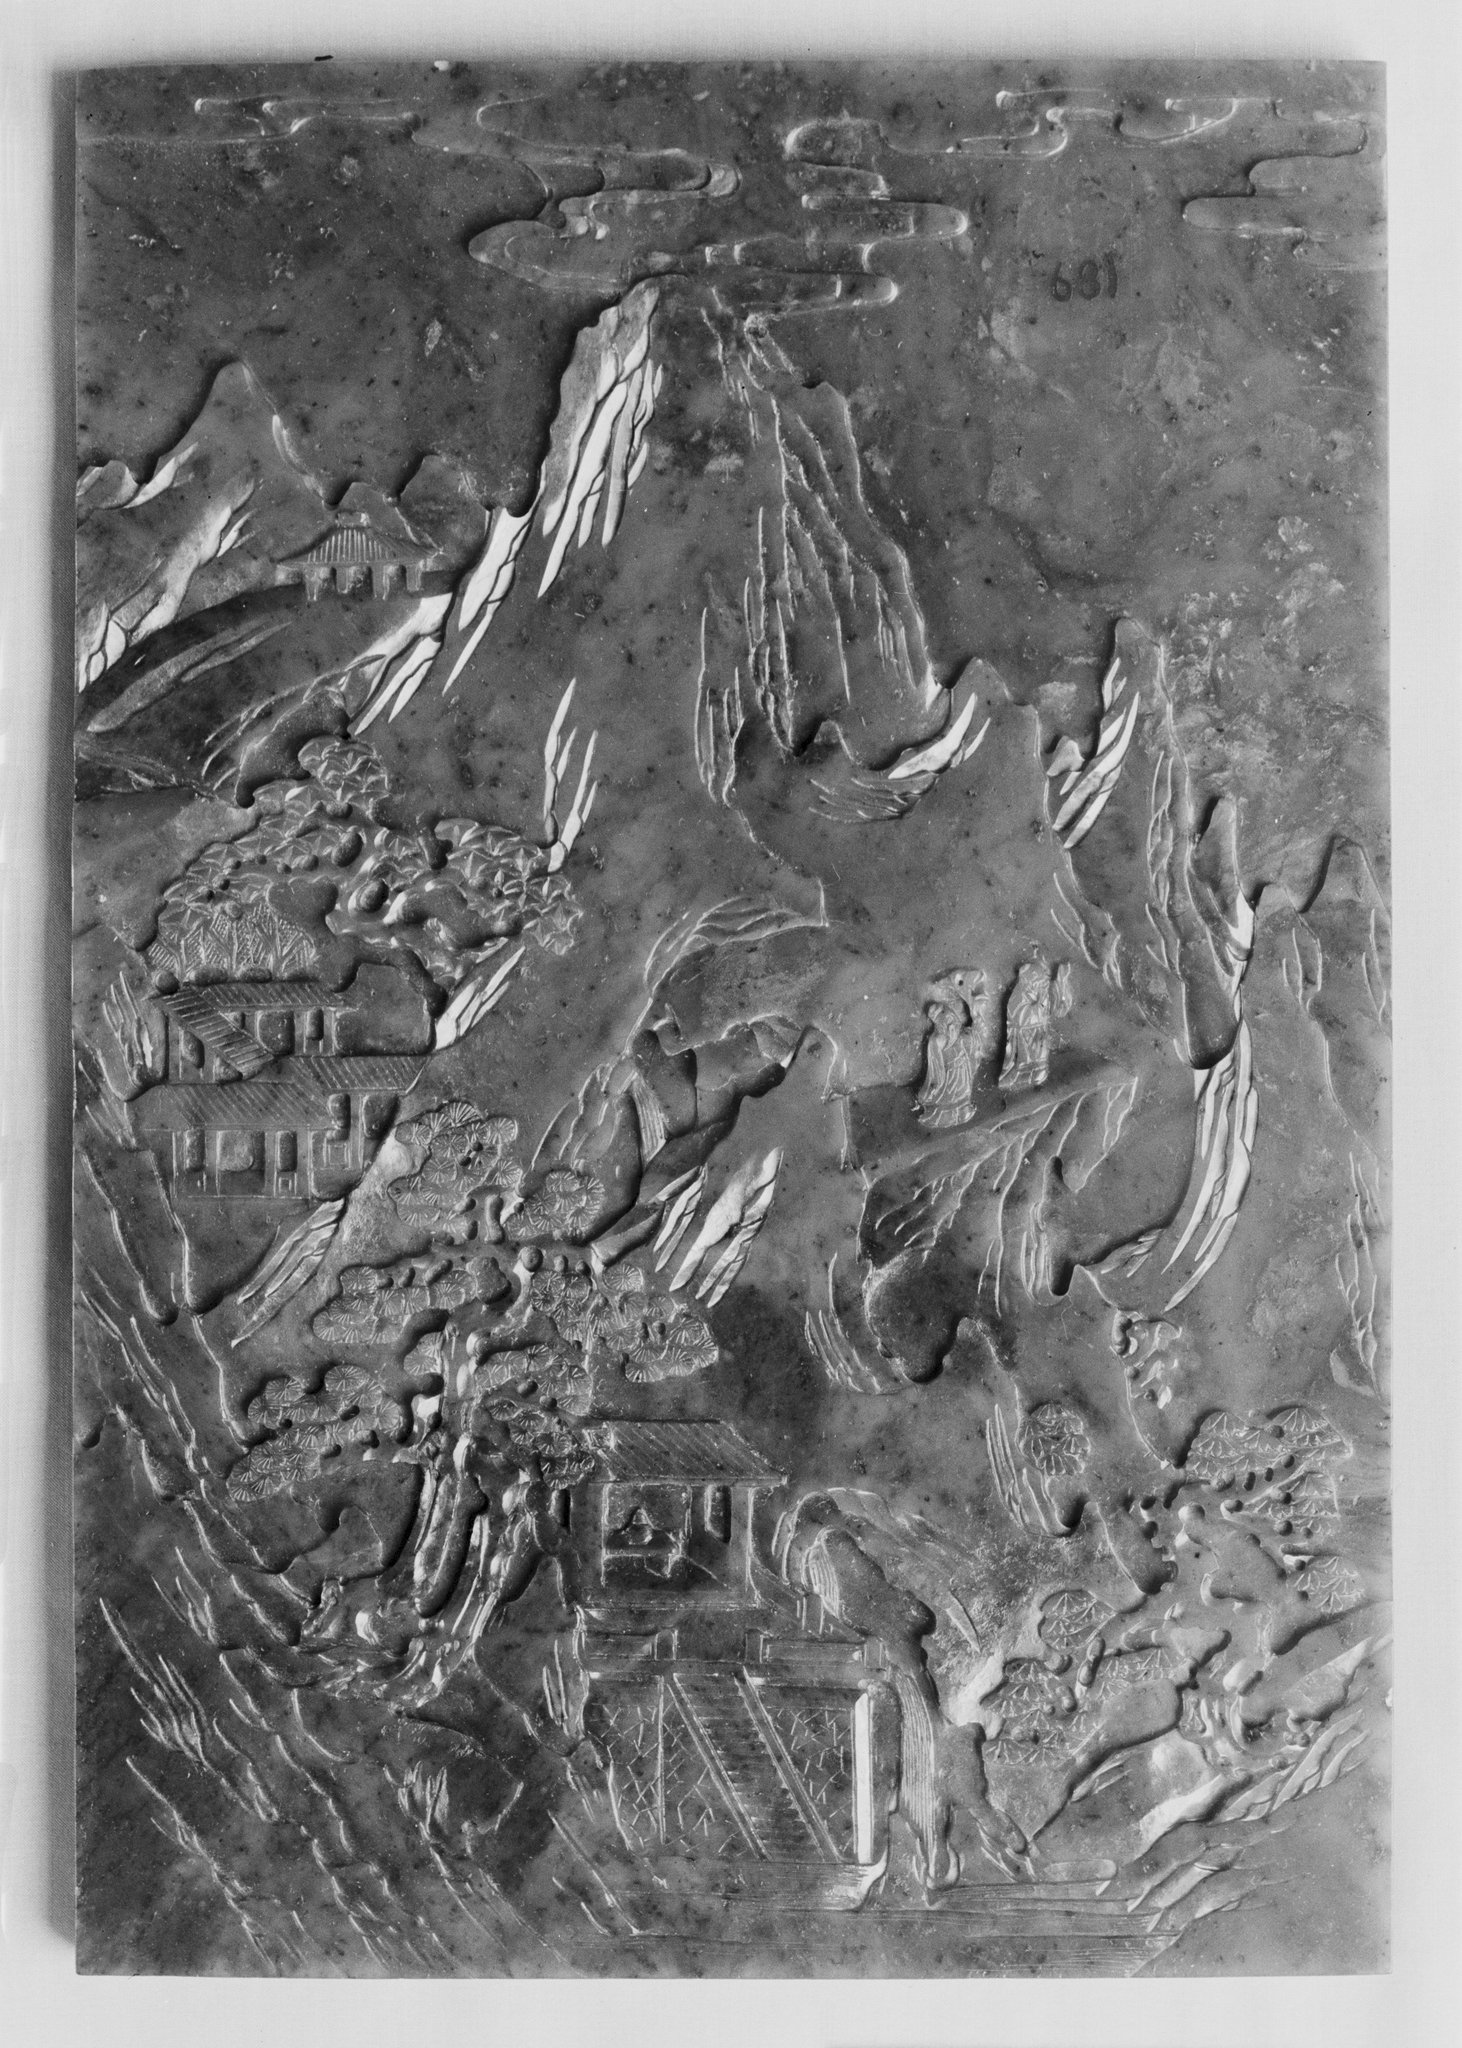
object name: table screen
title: Table screen with land of immortals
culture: chinese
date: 1701-1900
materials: jade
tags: mountains,trees